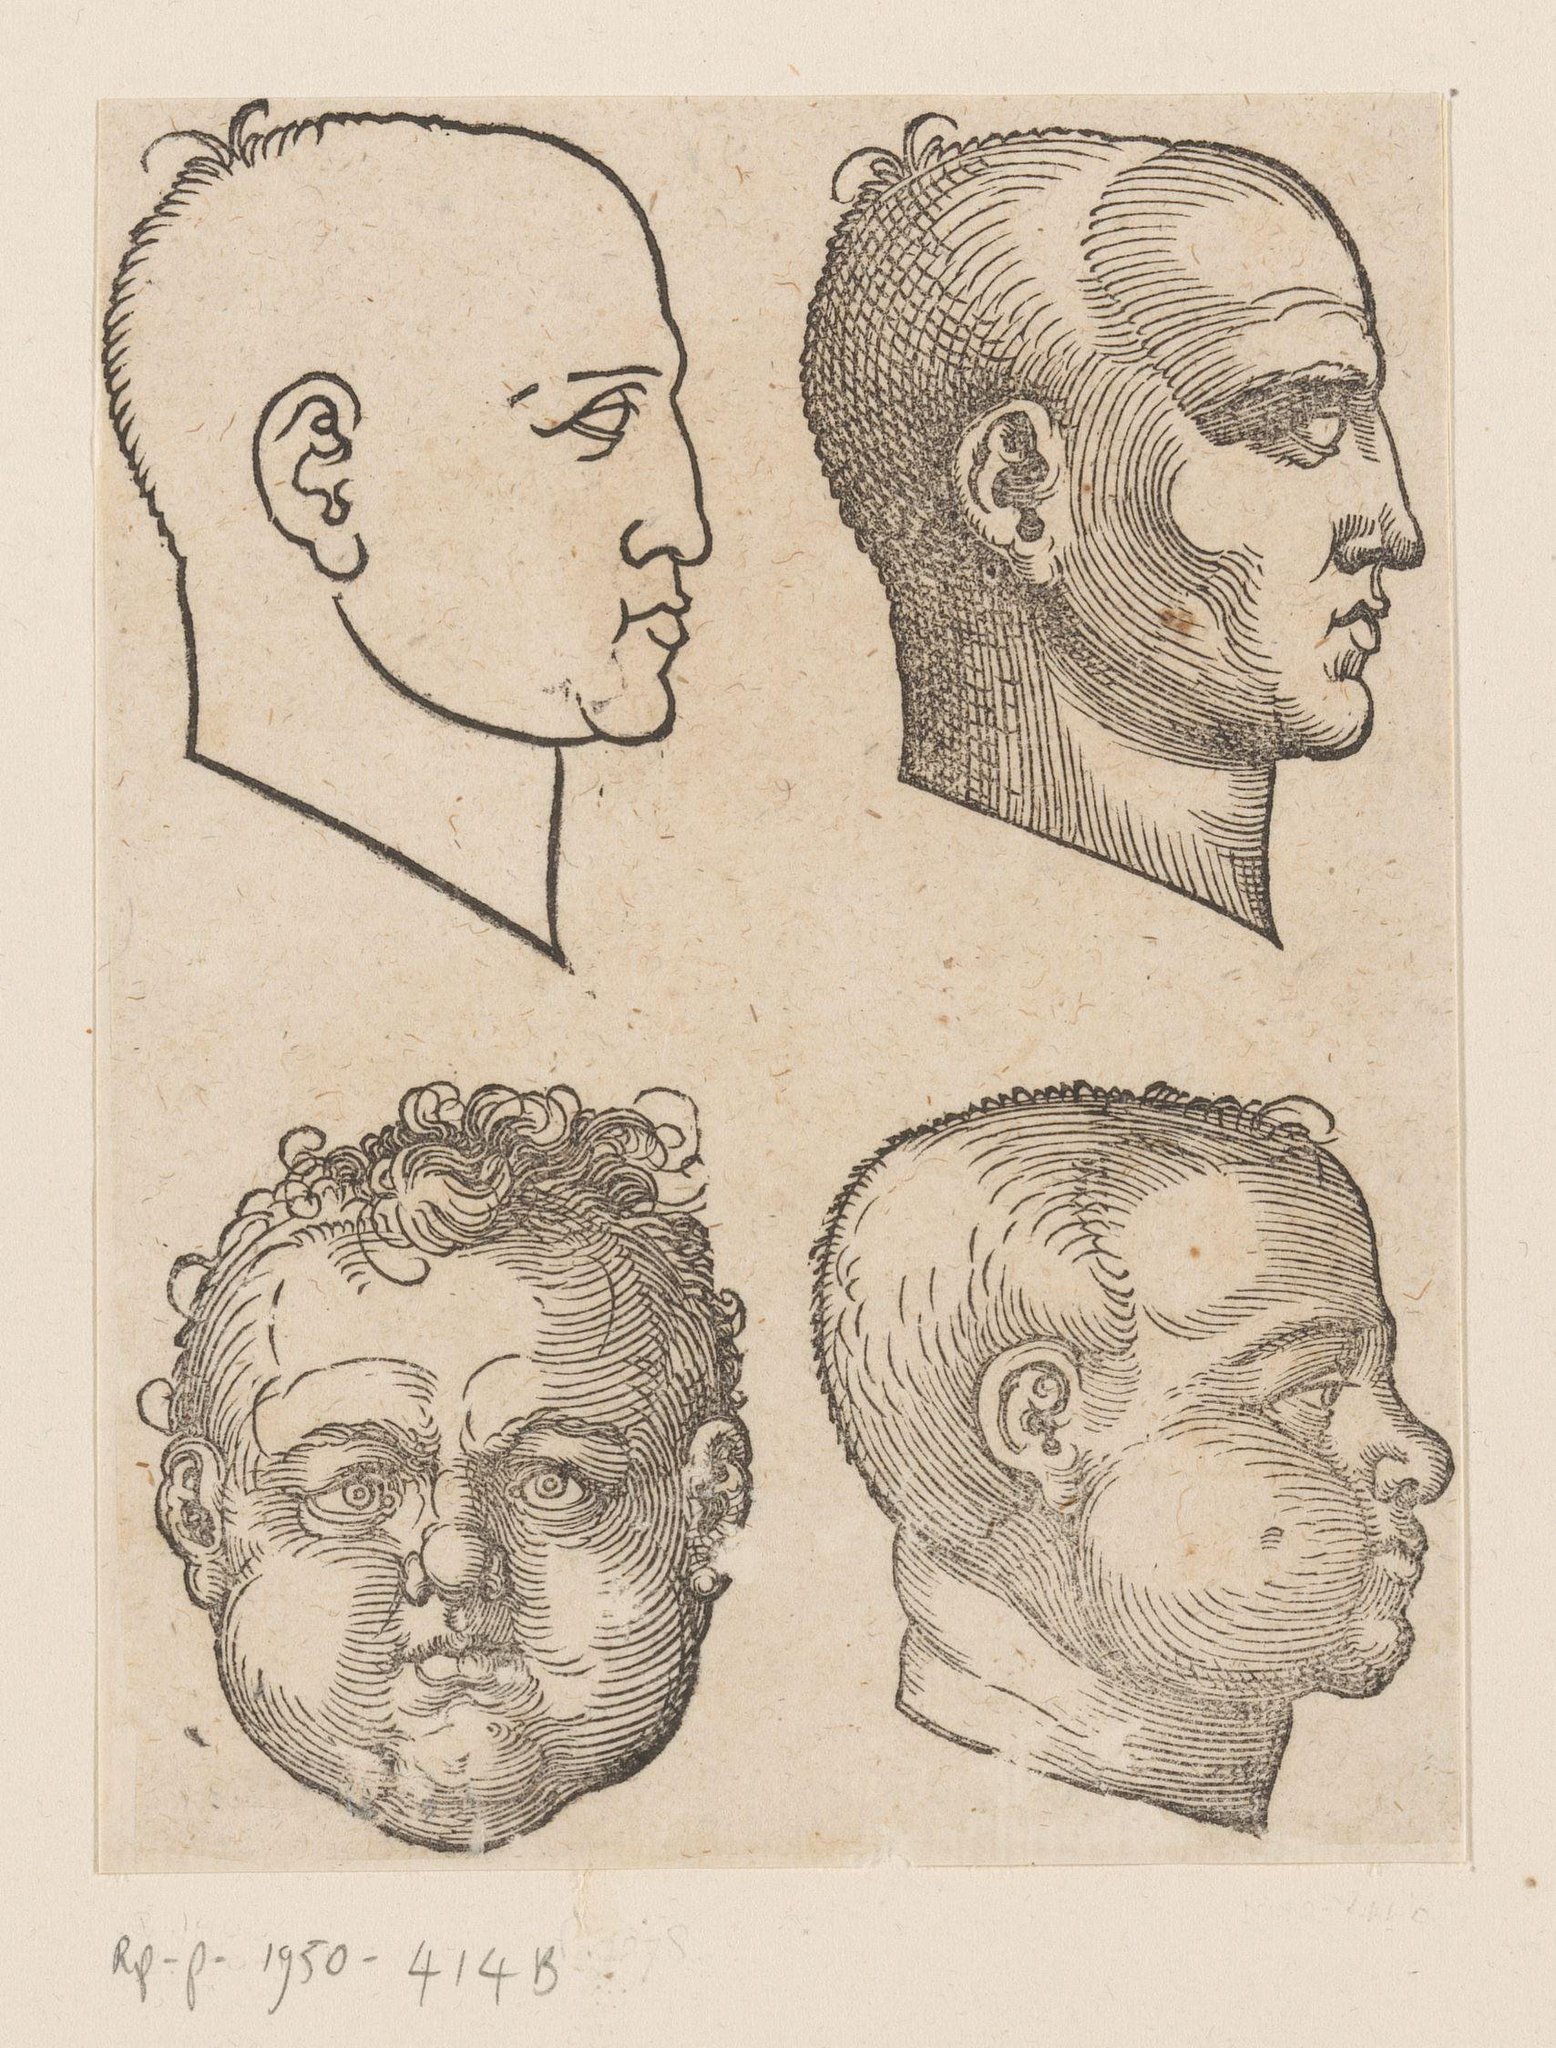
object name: print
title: Modellen voor gezichten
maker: Anonymous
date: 1565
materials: paper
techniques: woodcut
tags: anatomy (non-medical), model-books ~ implements of painter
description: Prent afkomstig uit: Beham, Hans Sebald. Sebalden Behems Kunst und Ler Büchlin (...). Frankfurt am Main: erven Christian Egenolff, 1565.